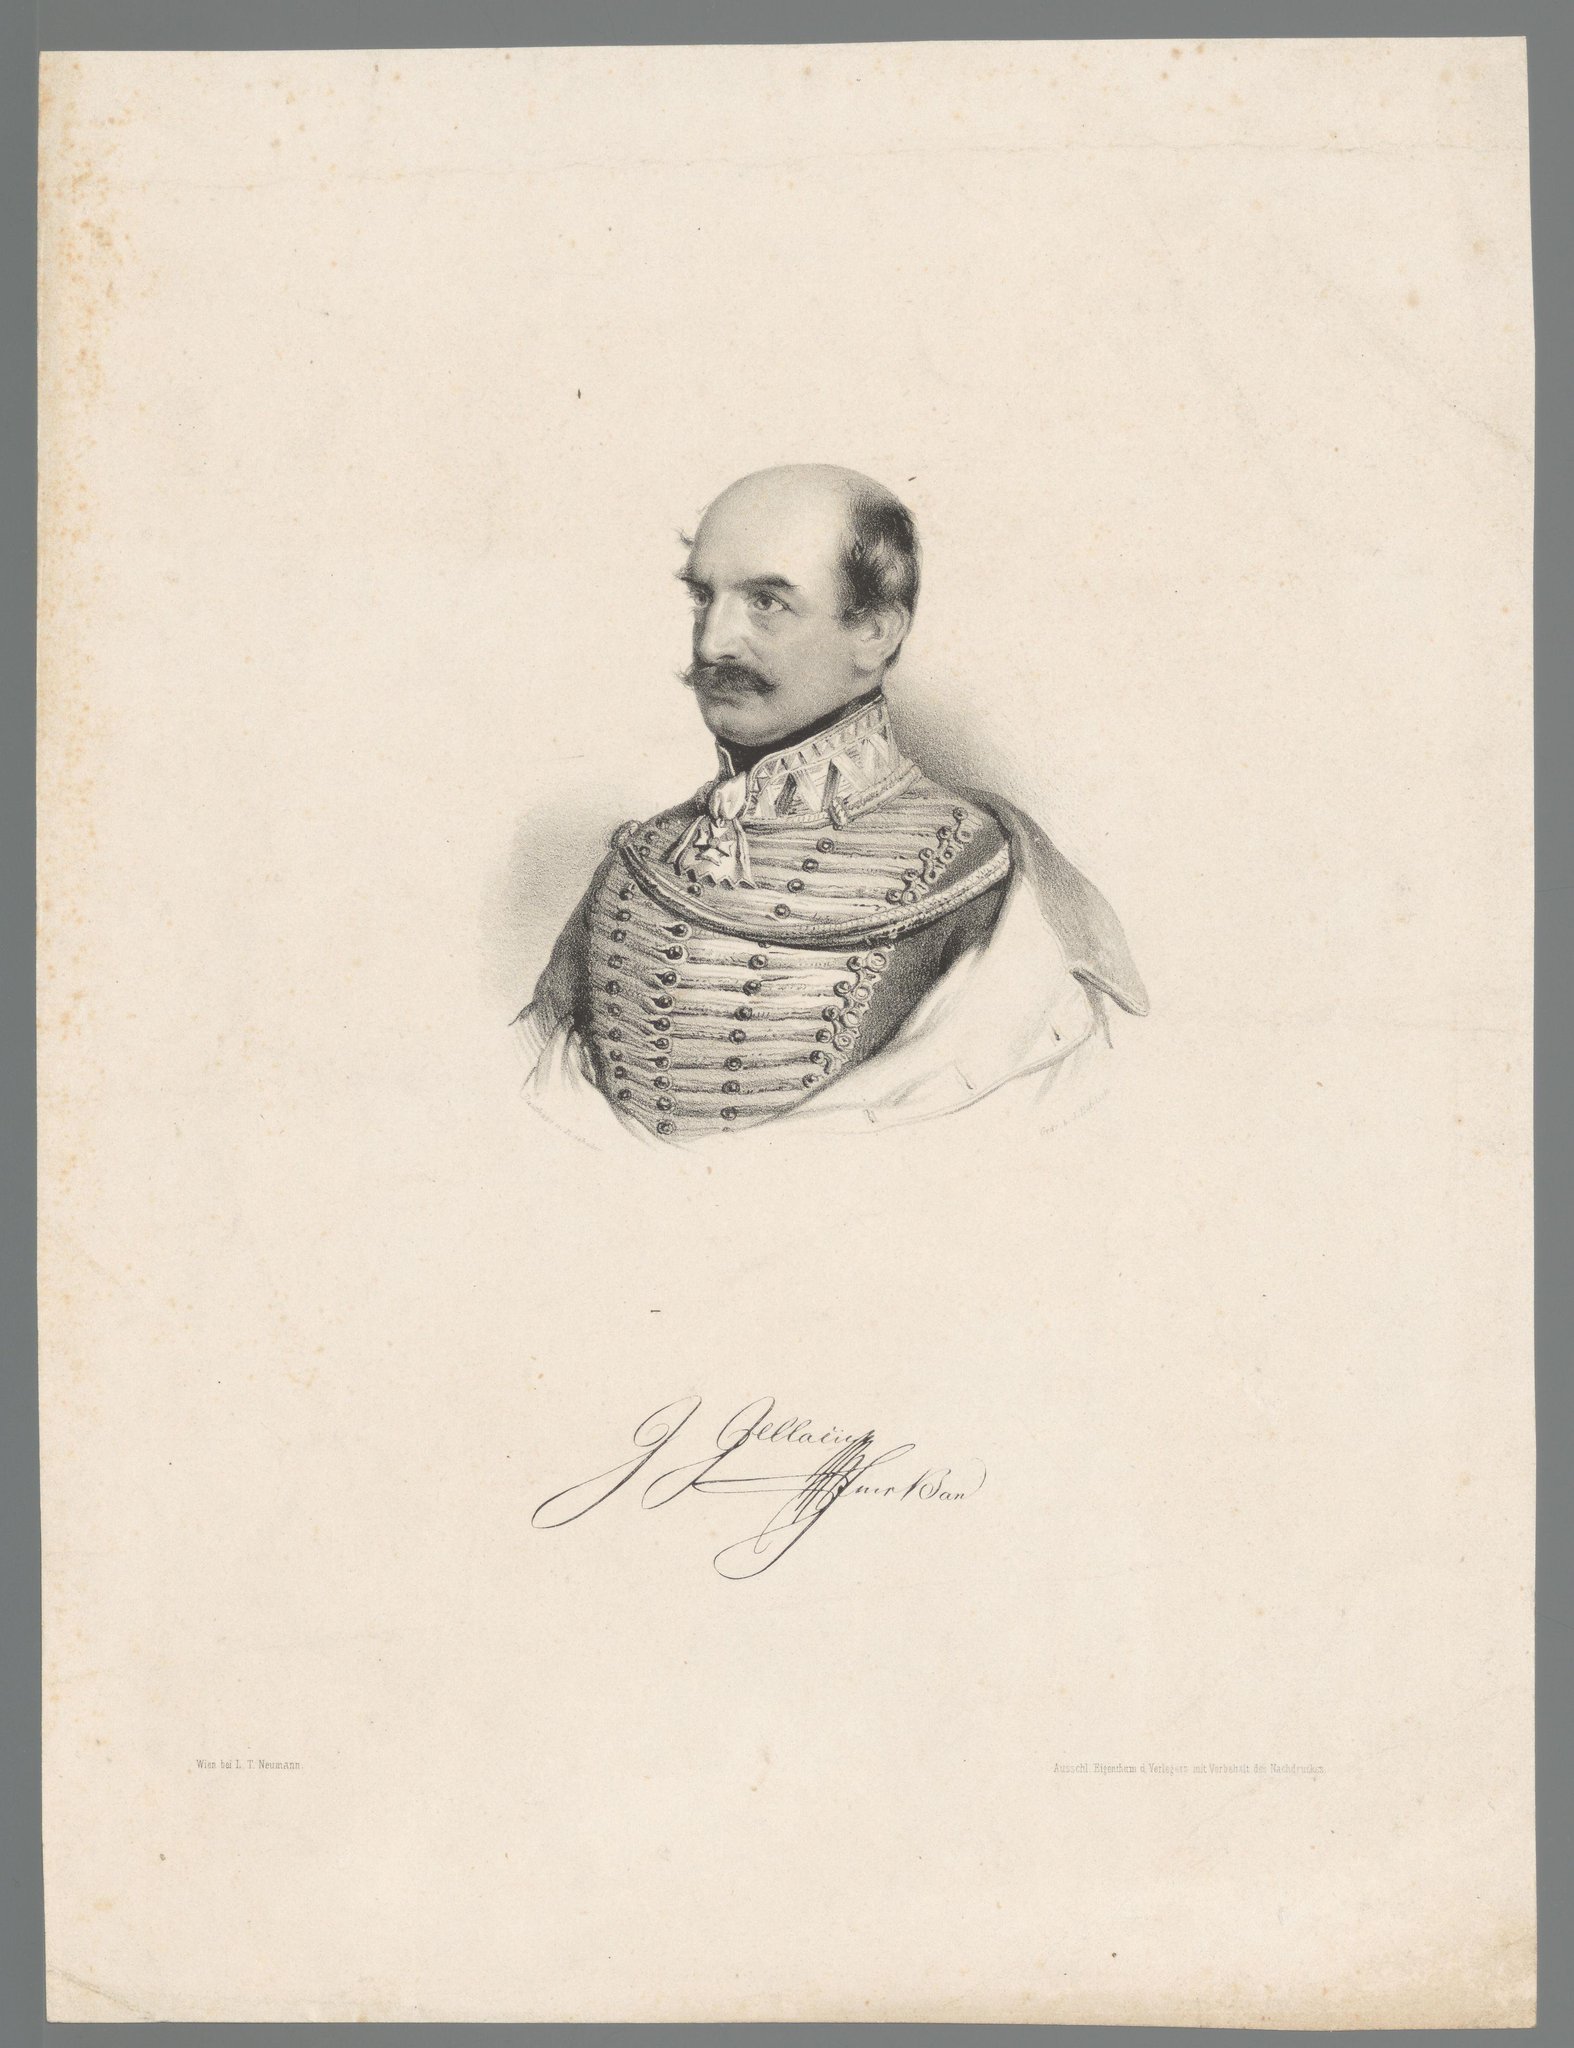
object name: print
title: Portret van een onbekende man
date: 1835-1849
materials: paper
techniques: lithograph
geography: vienna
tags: historical persons not known by name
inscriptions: collector's mark: Lugt 2228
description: Portret van een verder onbekende militair, met handtekening in facsimile waarin de naam Jellain of Jellaun te lezen is.